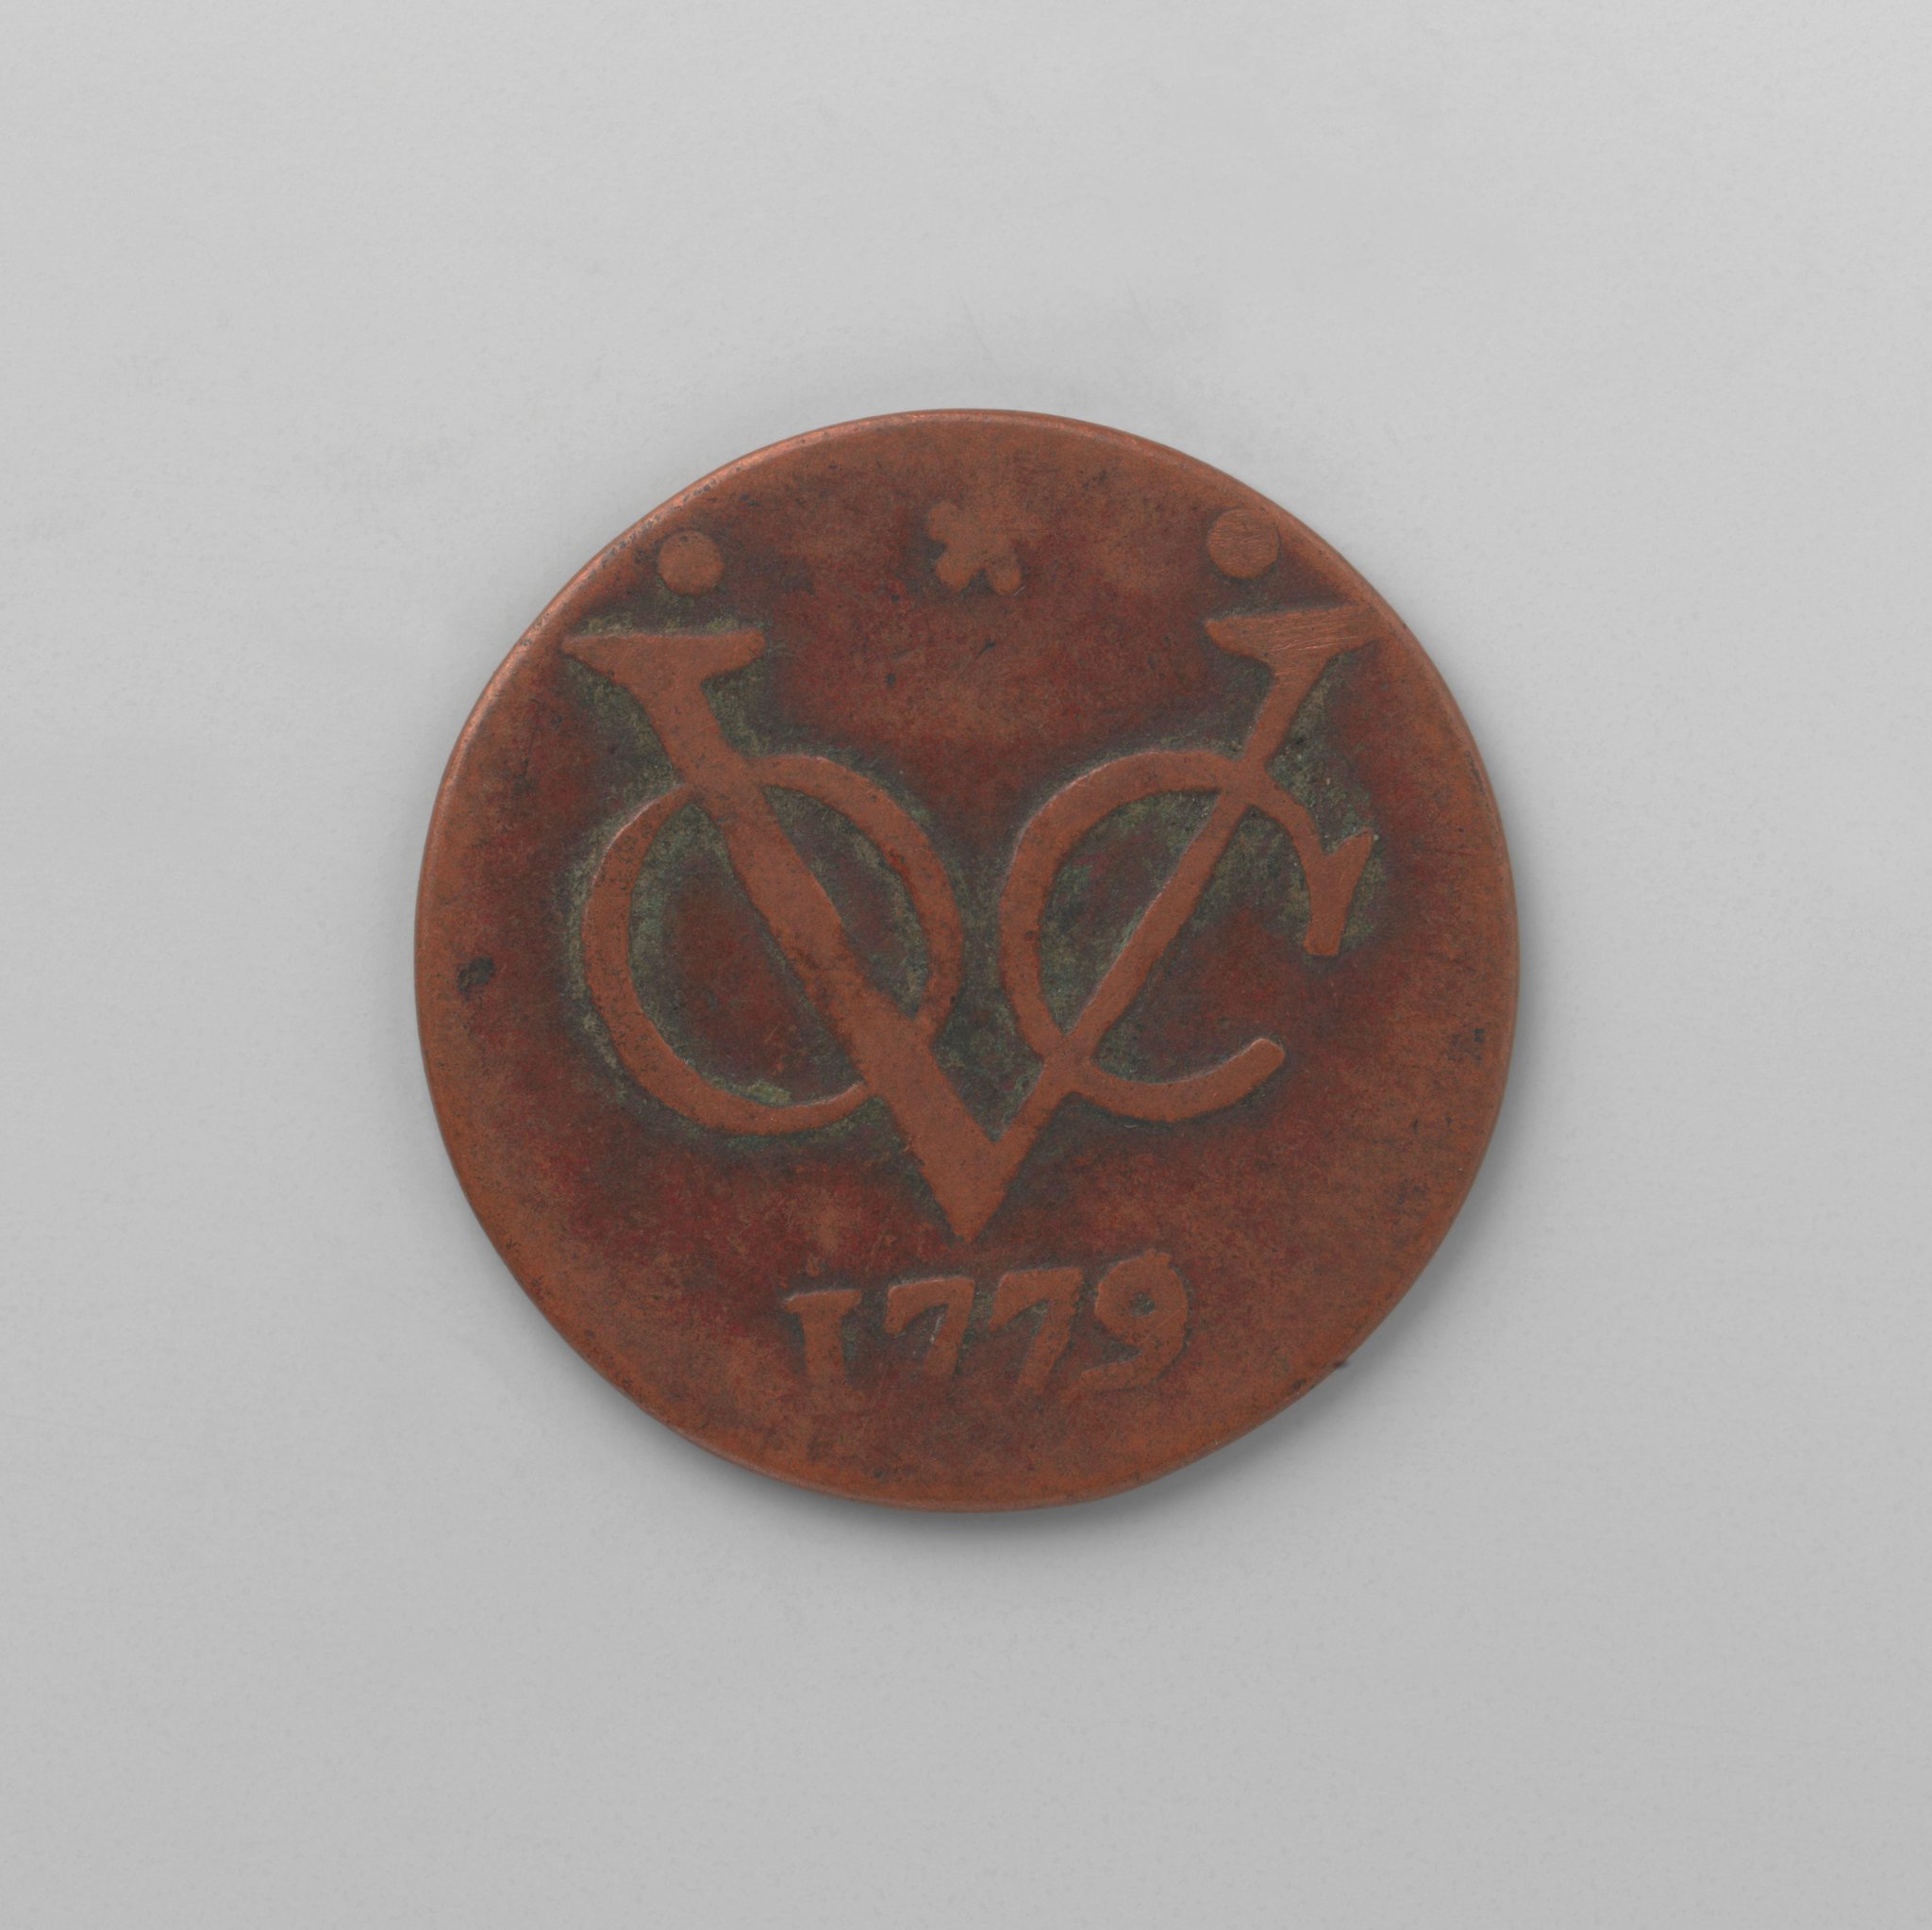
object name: coin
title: Duit van de VOC uit Westfriesland,1779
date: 1779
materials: copper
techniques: striking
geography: medemblik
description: Koperen munt. Voorzijde: gekroond wapenschild van Westfriesland. Keerzijde: monogram van de VOC, waarboven muntteken en waaronder jaartal. Gladde rand.